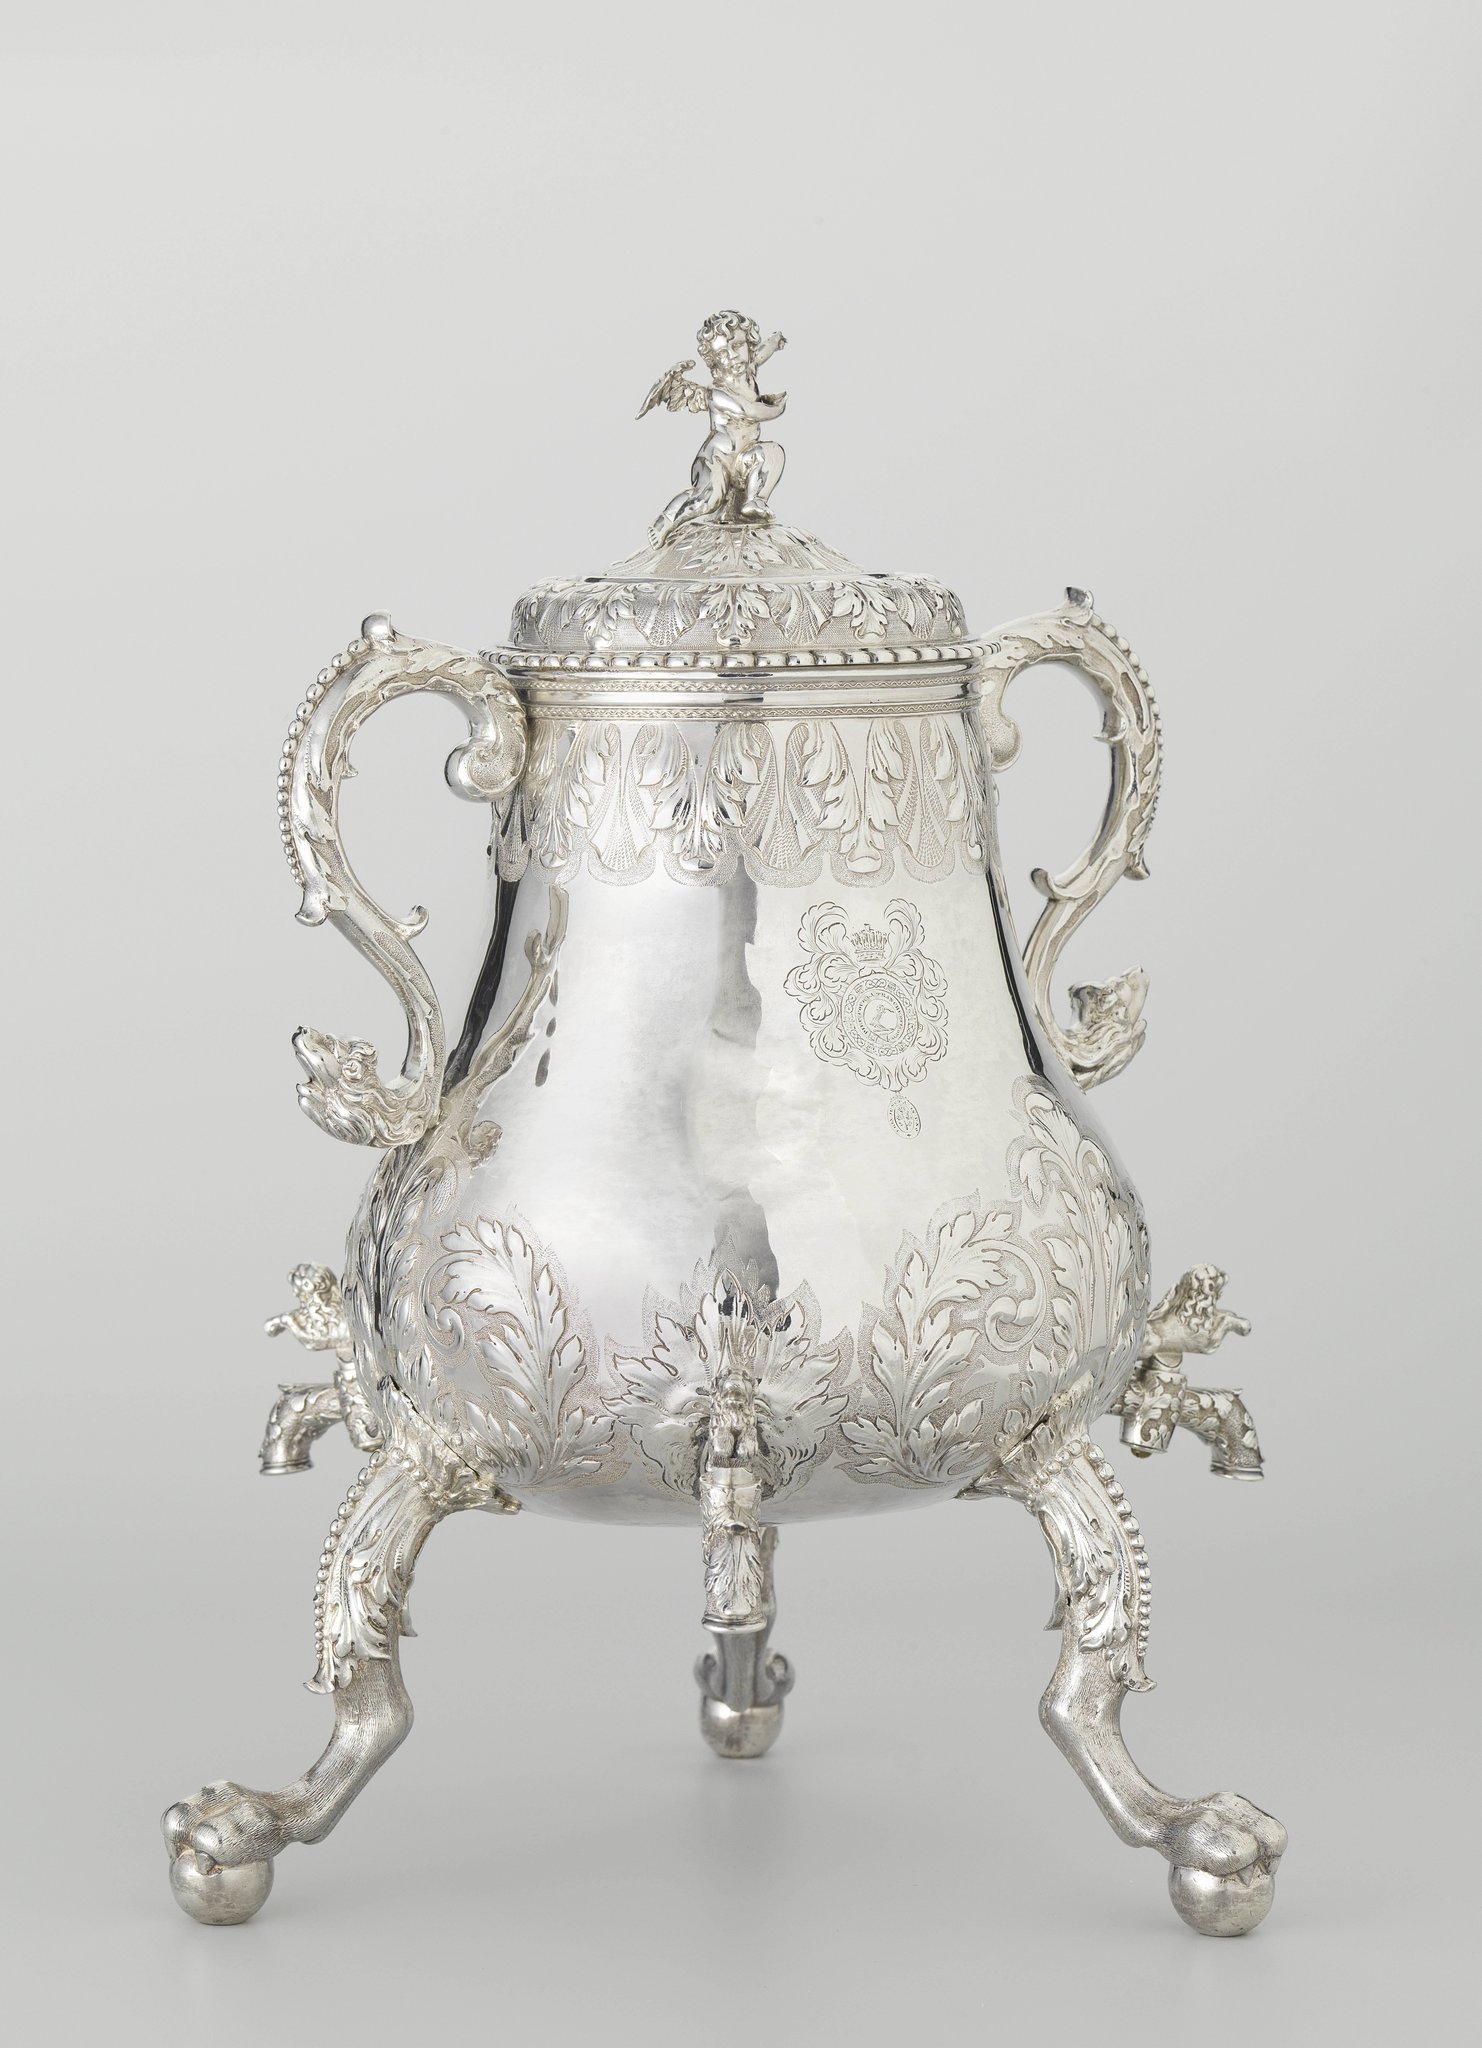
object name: coffee urn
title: Driekranenkan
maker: johannes jans de vos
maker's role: silversmith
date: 1700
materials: silver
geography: leeuwarden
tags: ornament derived from plant forms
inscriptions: mark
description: Coffee urn. Silver. Leeuwarden, 1700, by Johannes de Vos.